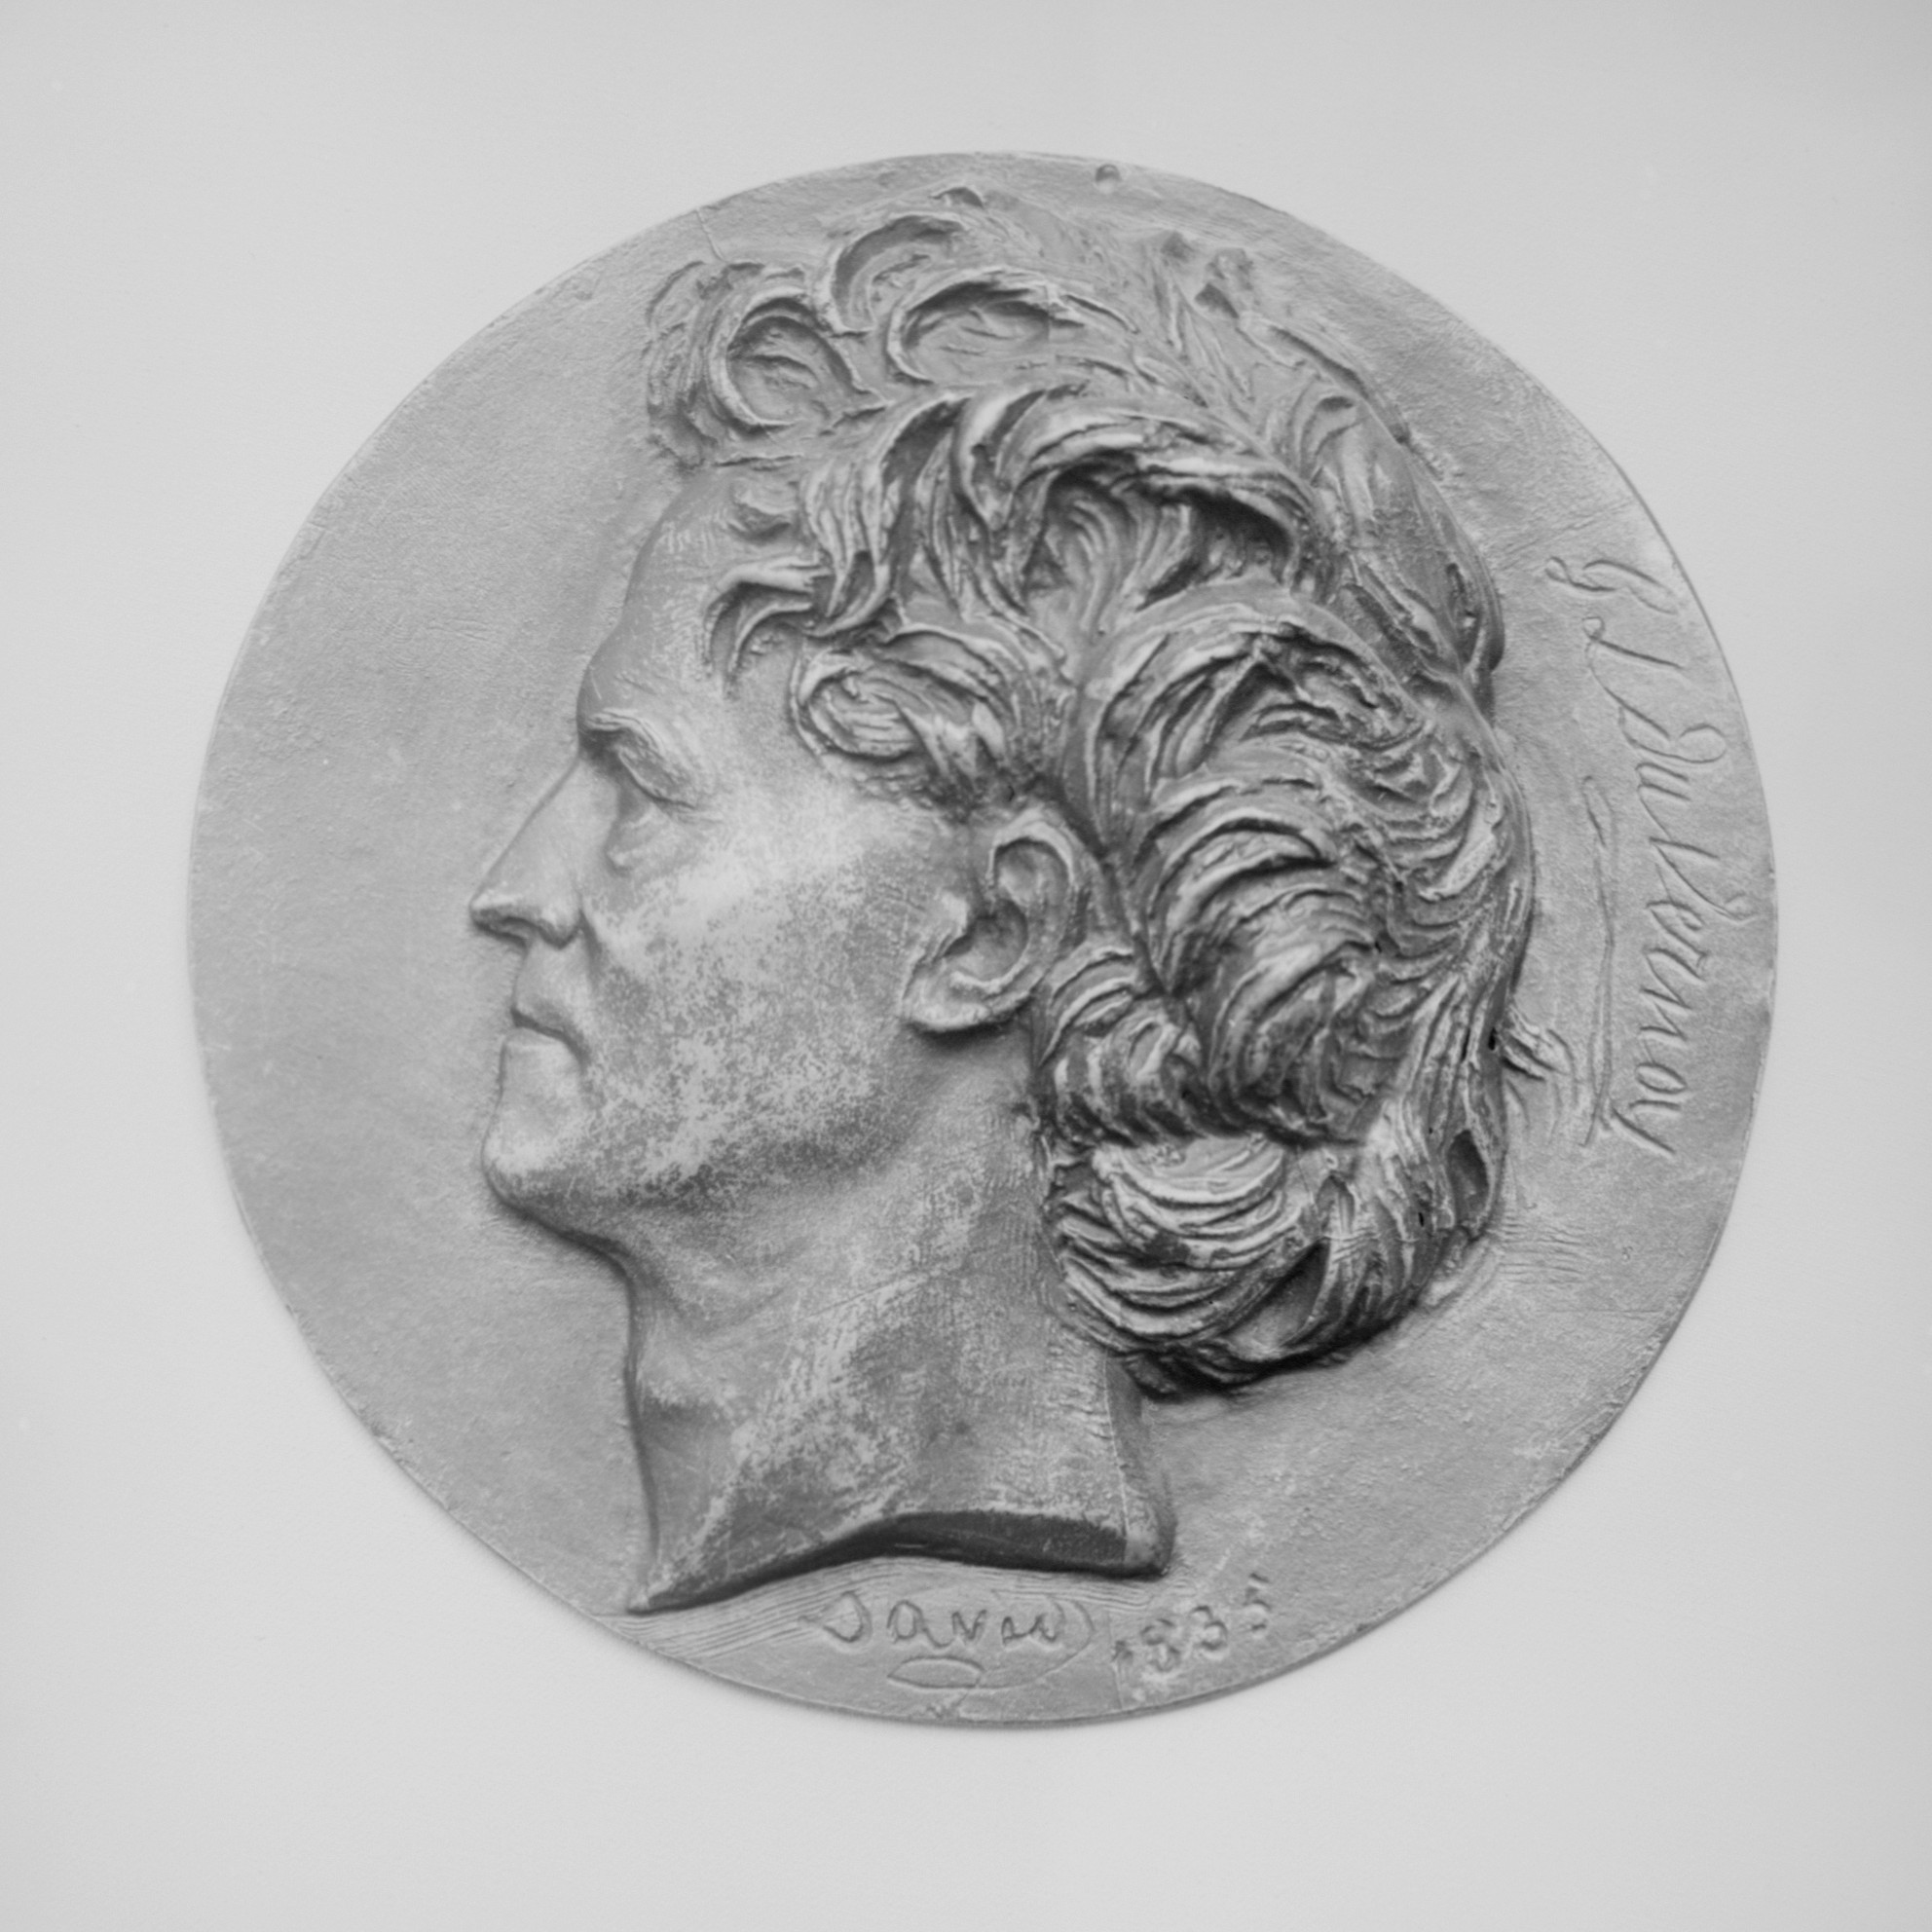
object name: medallion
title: Georges Louis DuVernoy (1777–1855), French naturalist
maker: pierre jean david d'angers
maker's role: artist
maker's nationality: french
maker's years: 1788-1856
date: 1835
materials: bronze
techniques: casting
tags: men,profiles